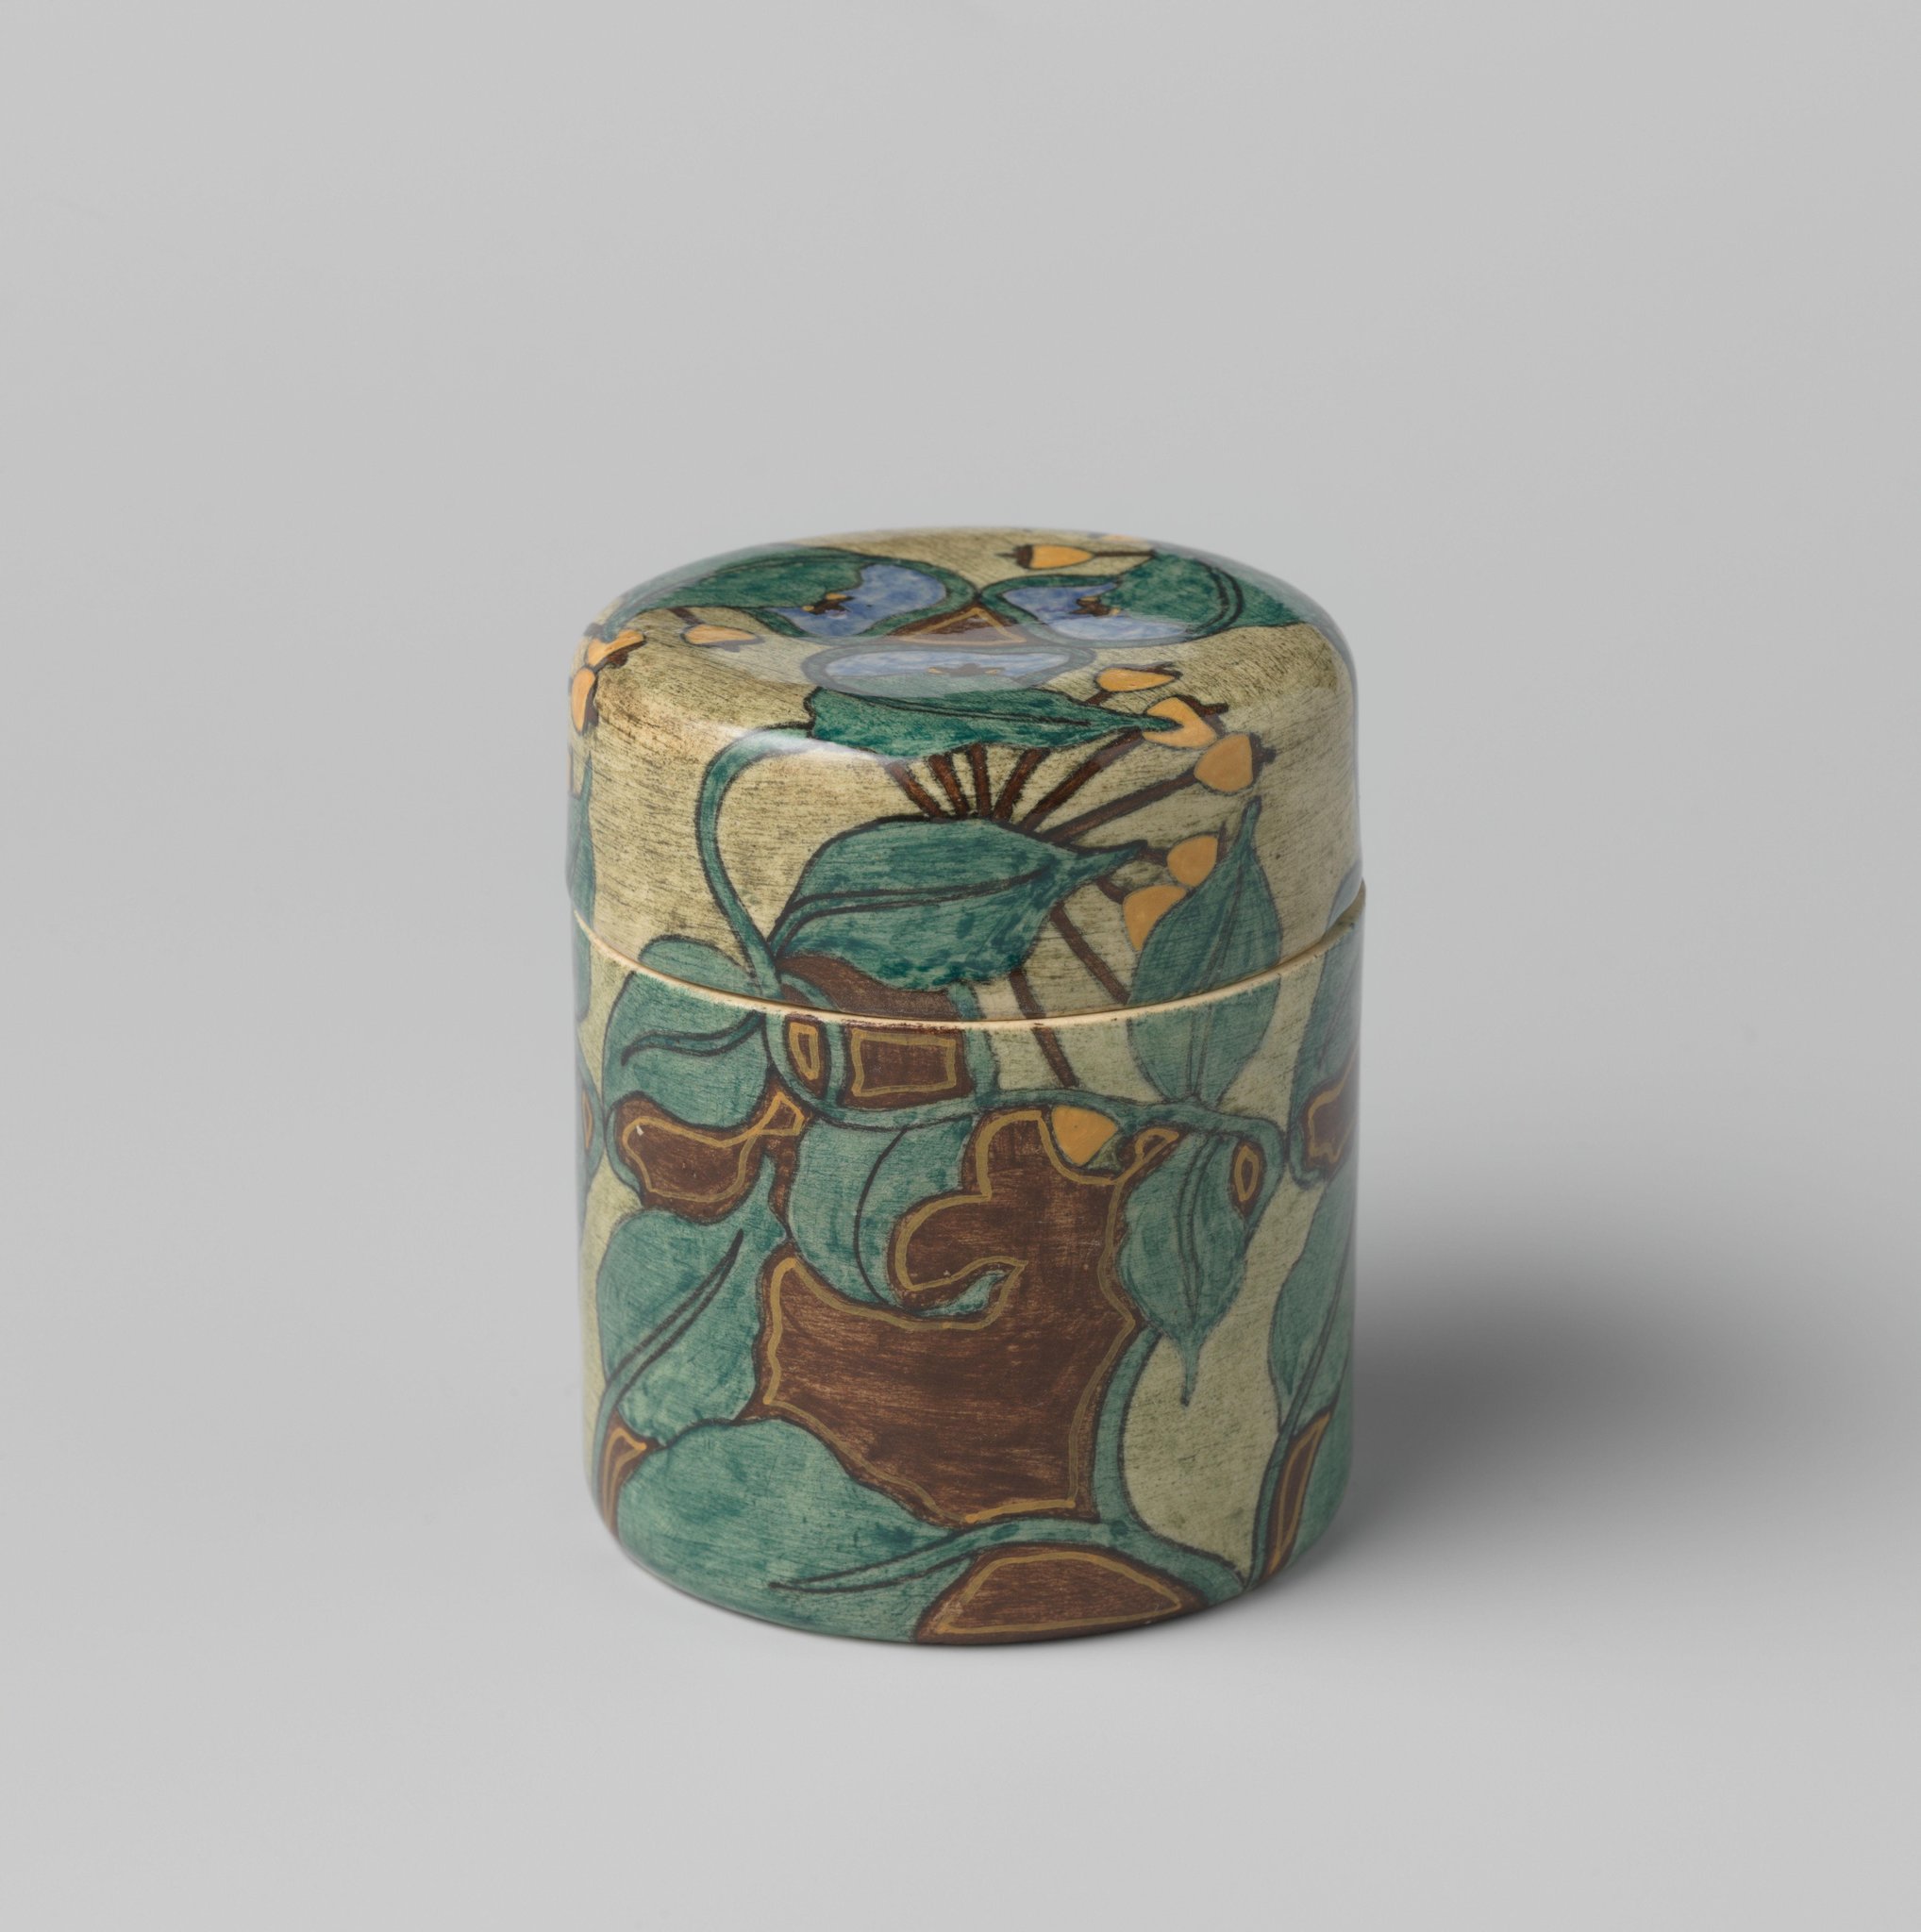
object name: lid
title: Deksel van doos, cilindervormig, beschilderd met bloemen en bladeren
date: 1895-1904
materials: earthenware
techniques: painted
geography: purmerend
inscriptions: mark: ‘driehoek in zwart’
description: Box. Earthenware. Purmerend, c. 1898 - 1904, made by Firma Wed. N.S.A. Brantjes, decorated by Gerardus Visser, factory under the direction of the widow of N.S.A. Brantjes.